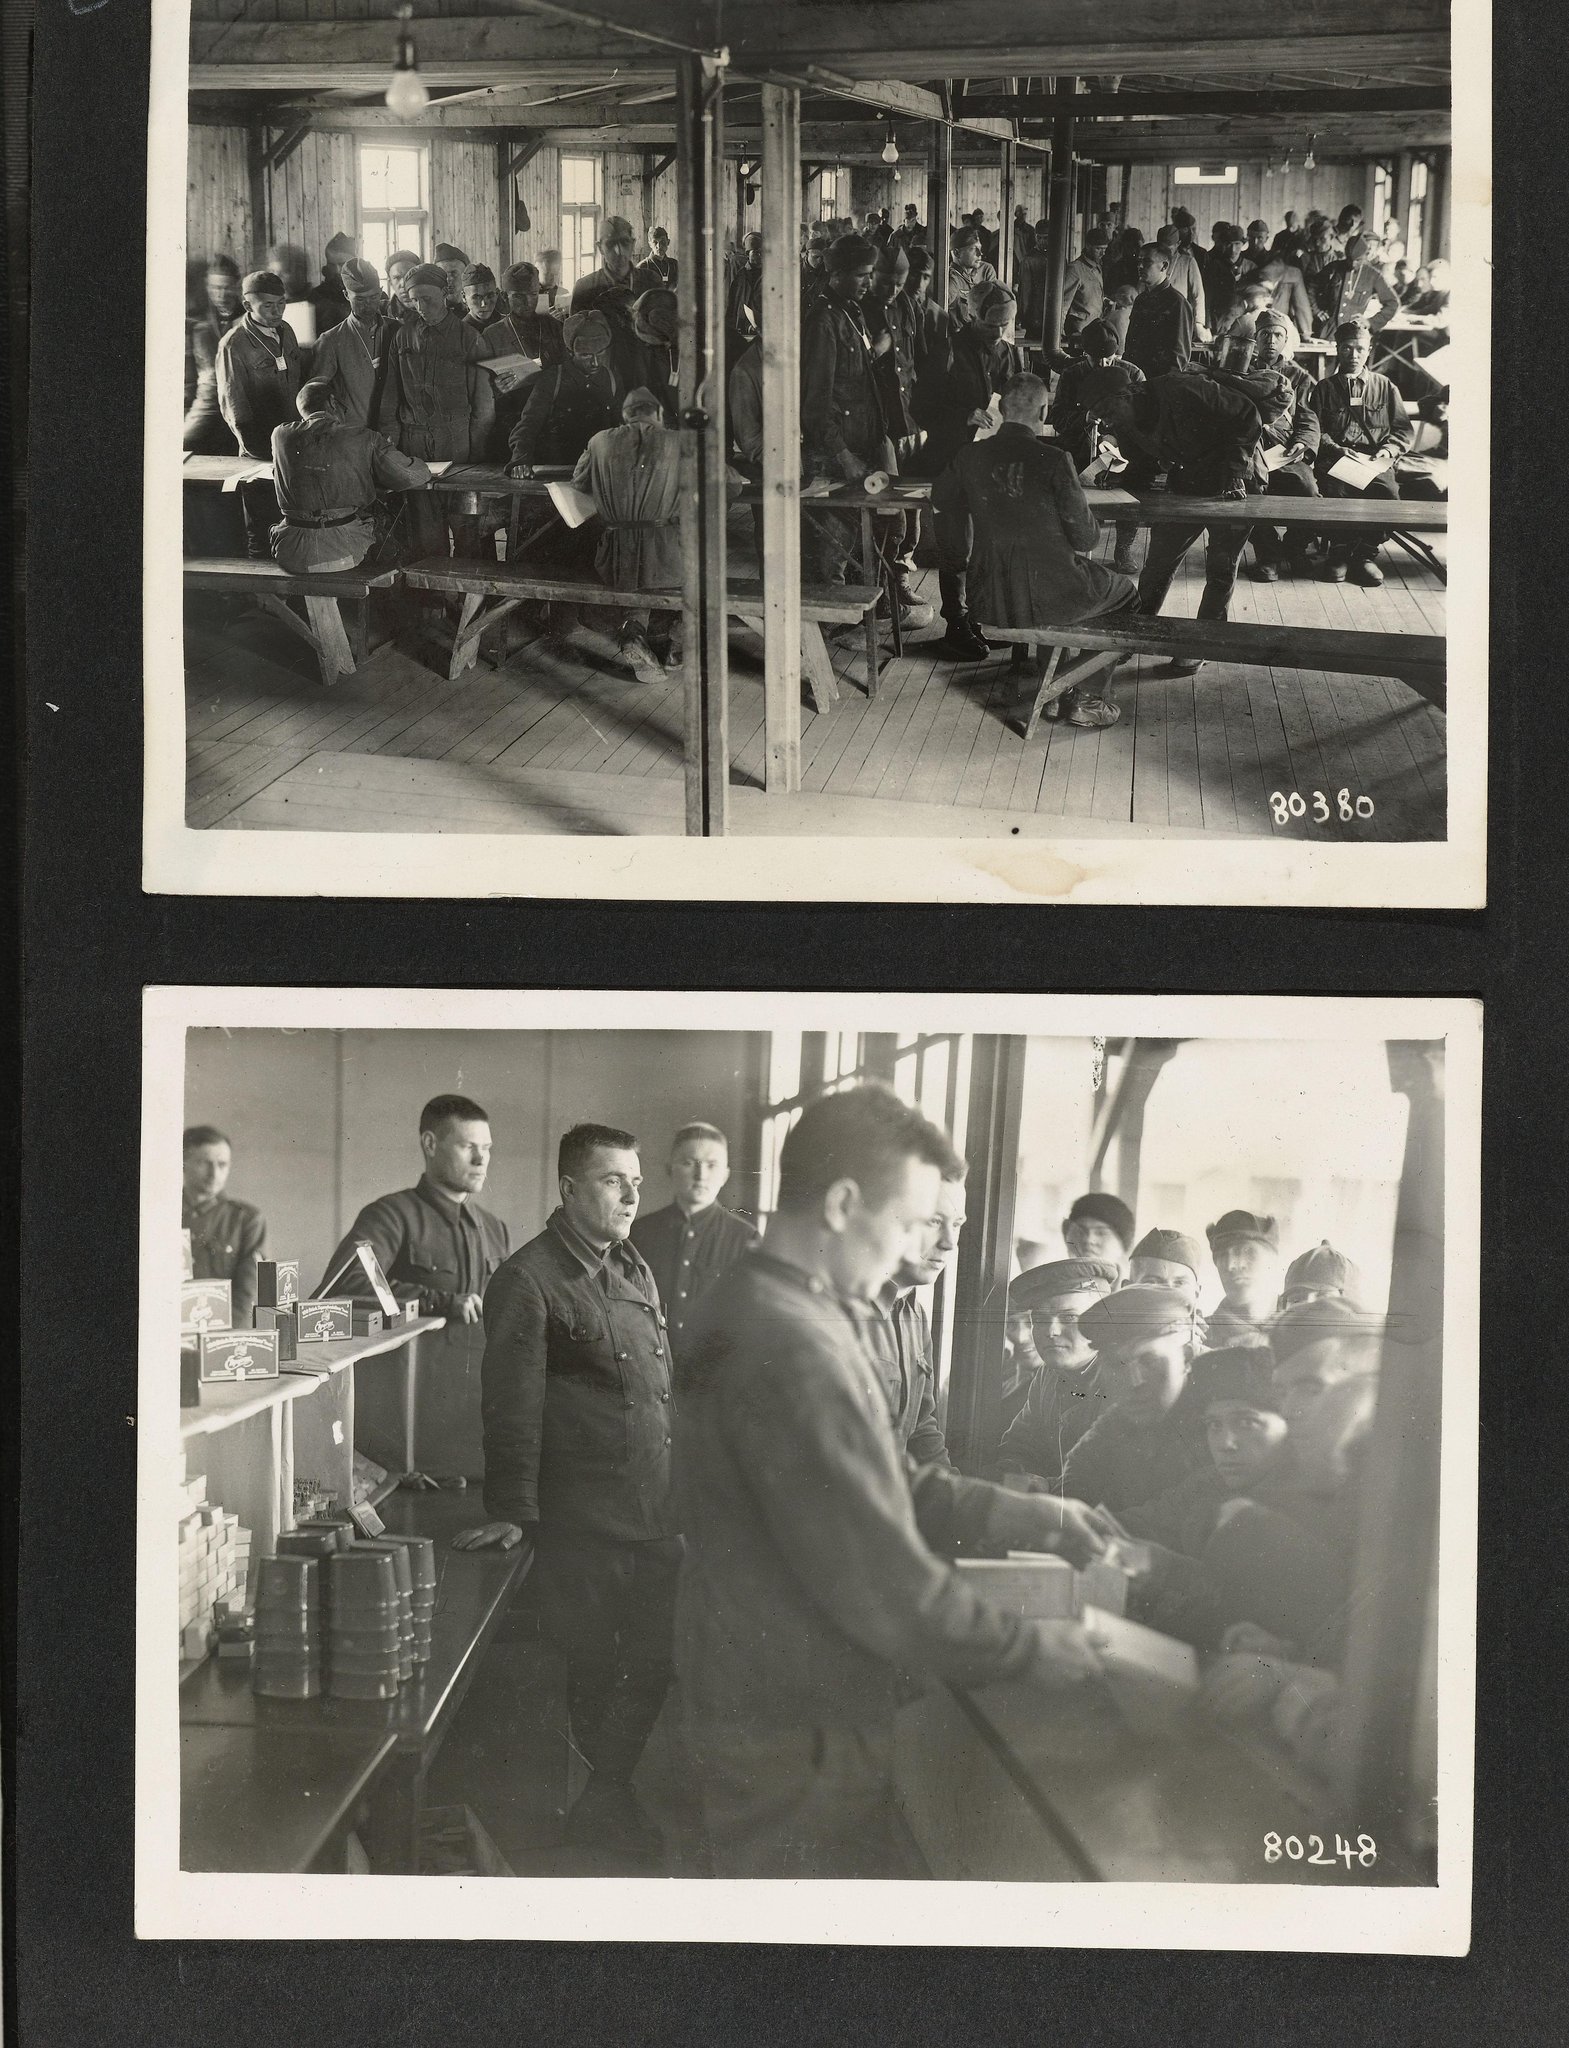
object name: photograph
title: Administratieruimte en kampwinkel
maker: dick w.b. van maarseveen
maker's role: fotograaf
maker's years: 1905-1990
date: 1943-1945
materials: cardboard, photographic support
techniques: gelatin silver print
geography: muhlberg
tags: the hague, dick w.b. van maarseveen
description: Albumblad met twee foto's: een lokaal waar formulieren ingevuld worden en de kampwinkel. Onderdeel van een fotoalbum met foto's door Dick van Maarseveen van het krijgsgevangenenkamp Stalag IV B in Mühlberg in de periode 1943-1945.